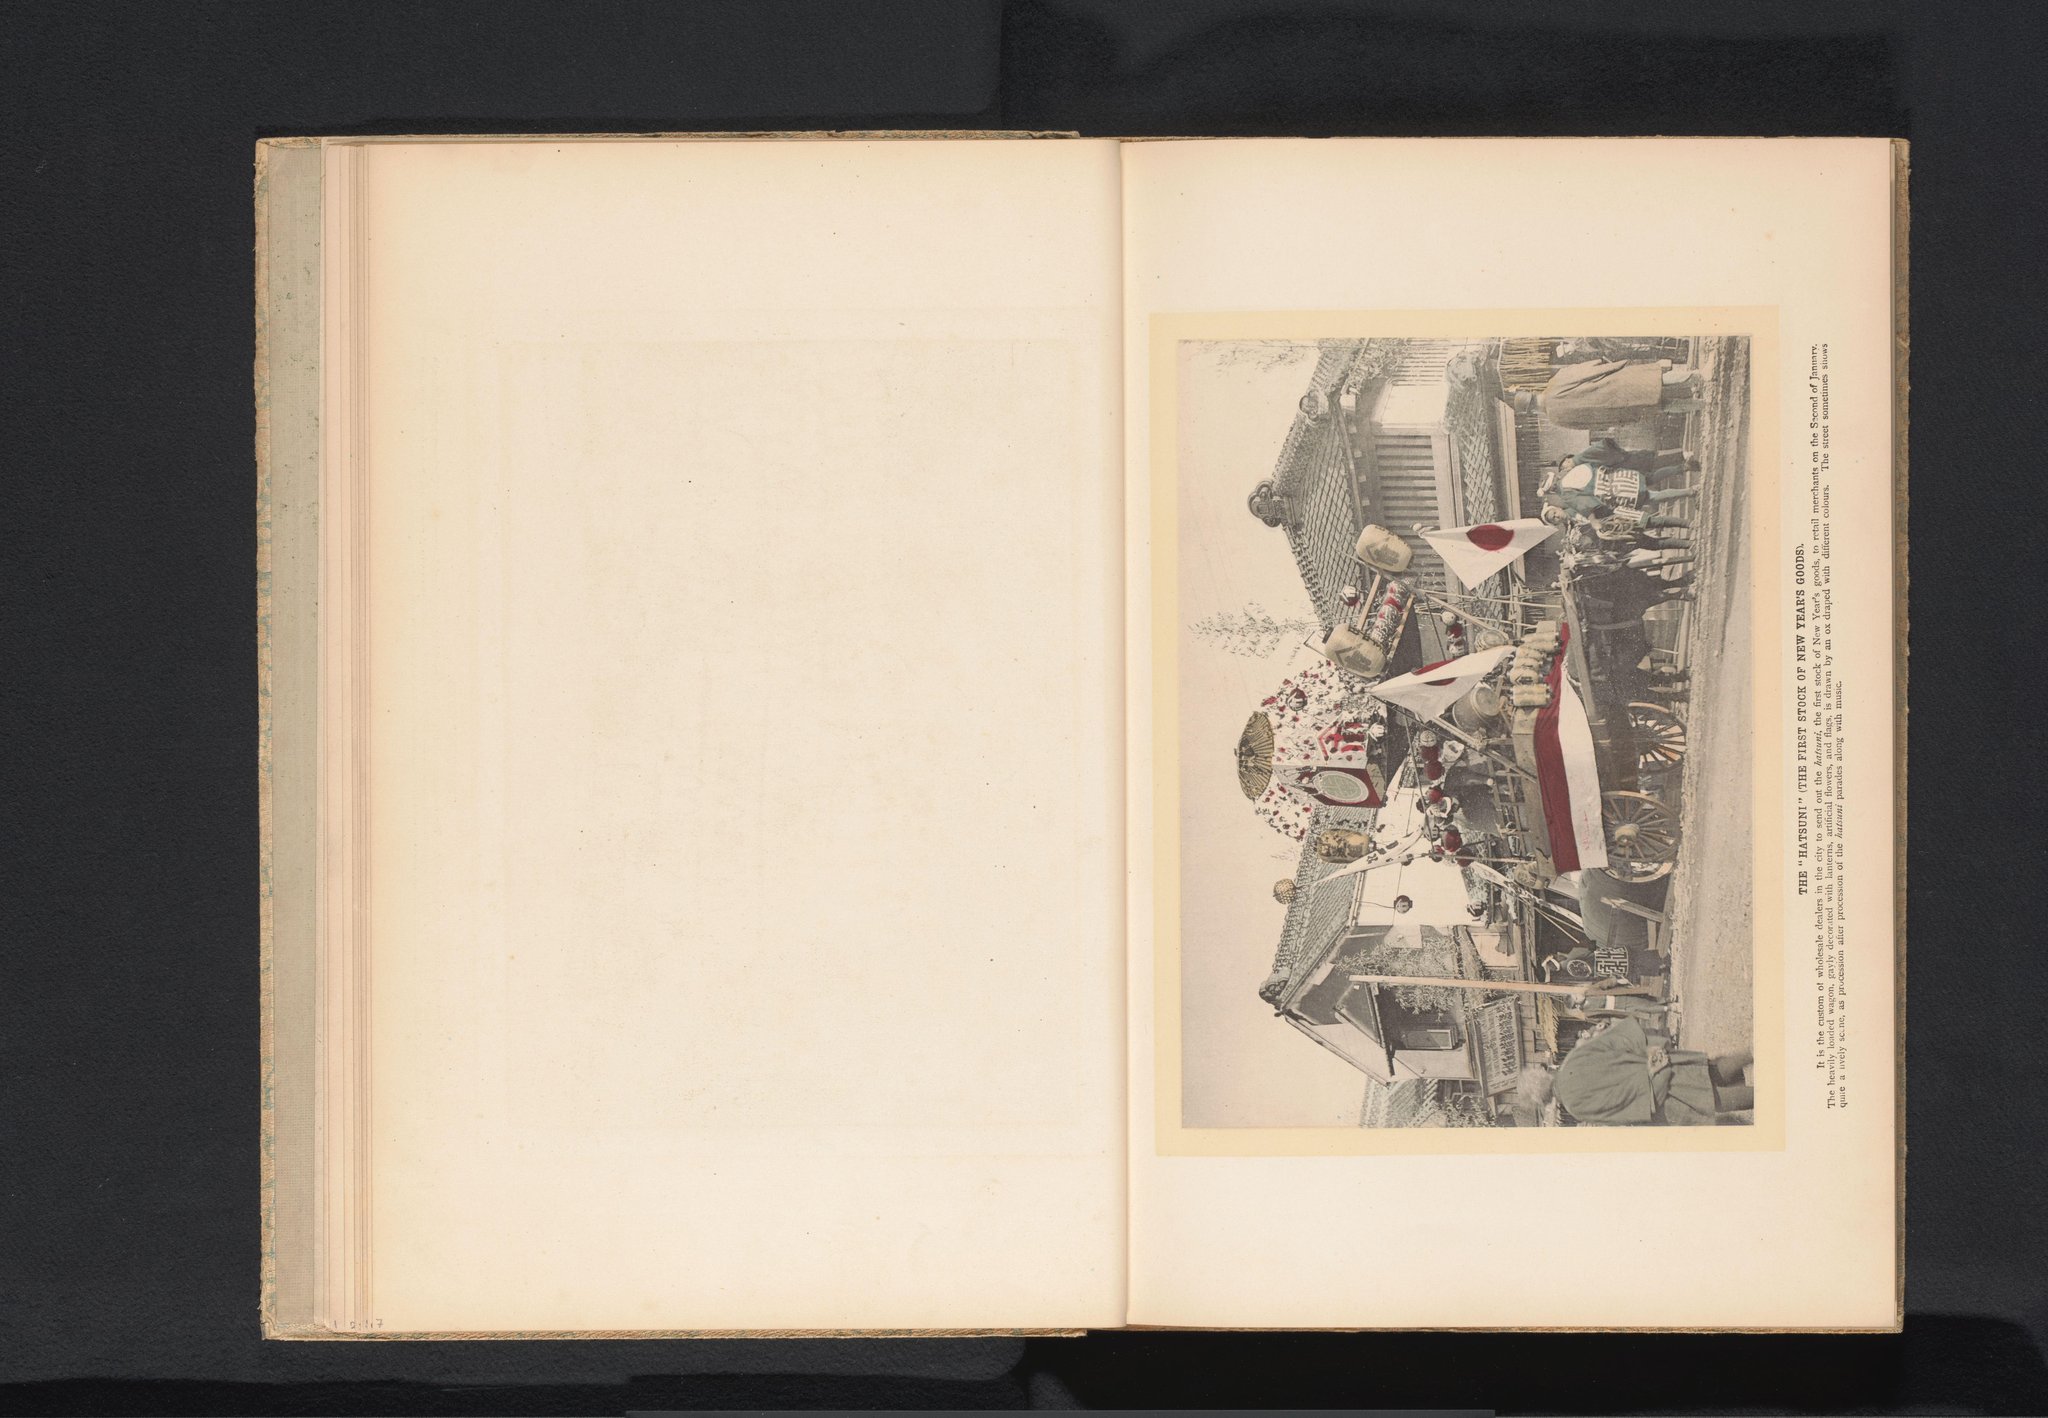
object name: photomechanical print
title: The "Hatsuni" (The First Stock of New Year's Goods)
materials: paper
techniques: photograph, lithograph, hand coloring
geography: tokyo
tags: street, two-wheeled vehicle drawn by one animal, japan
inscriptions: inscription: ‘It is (...) with music.’